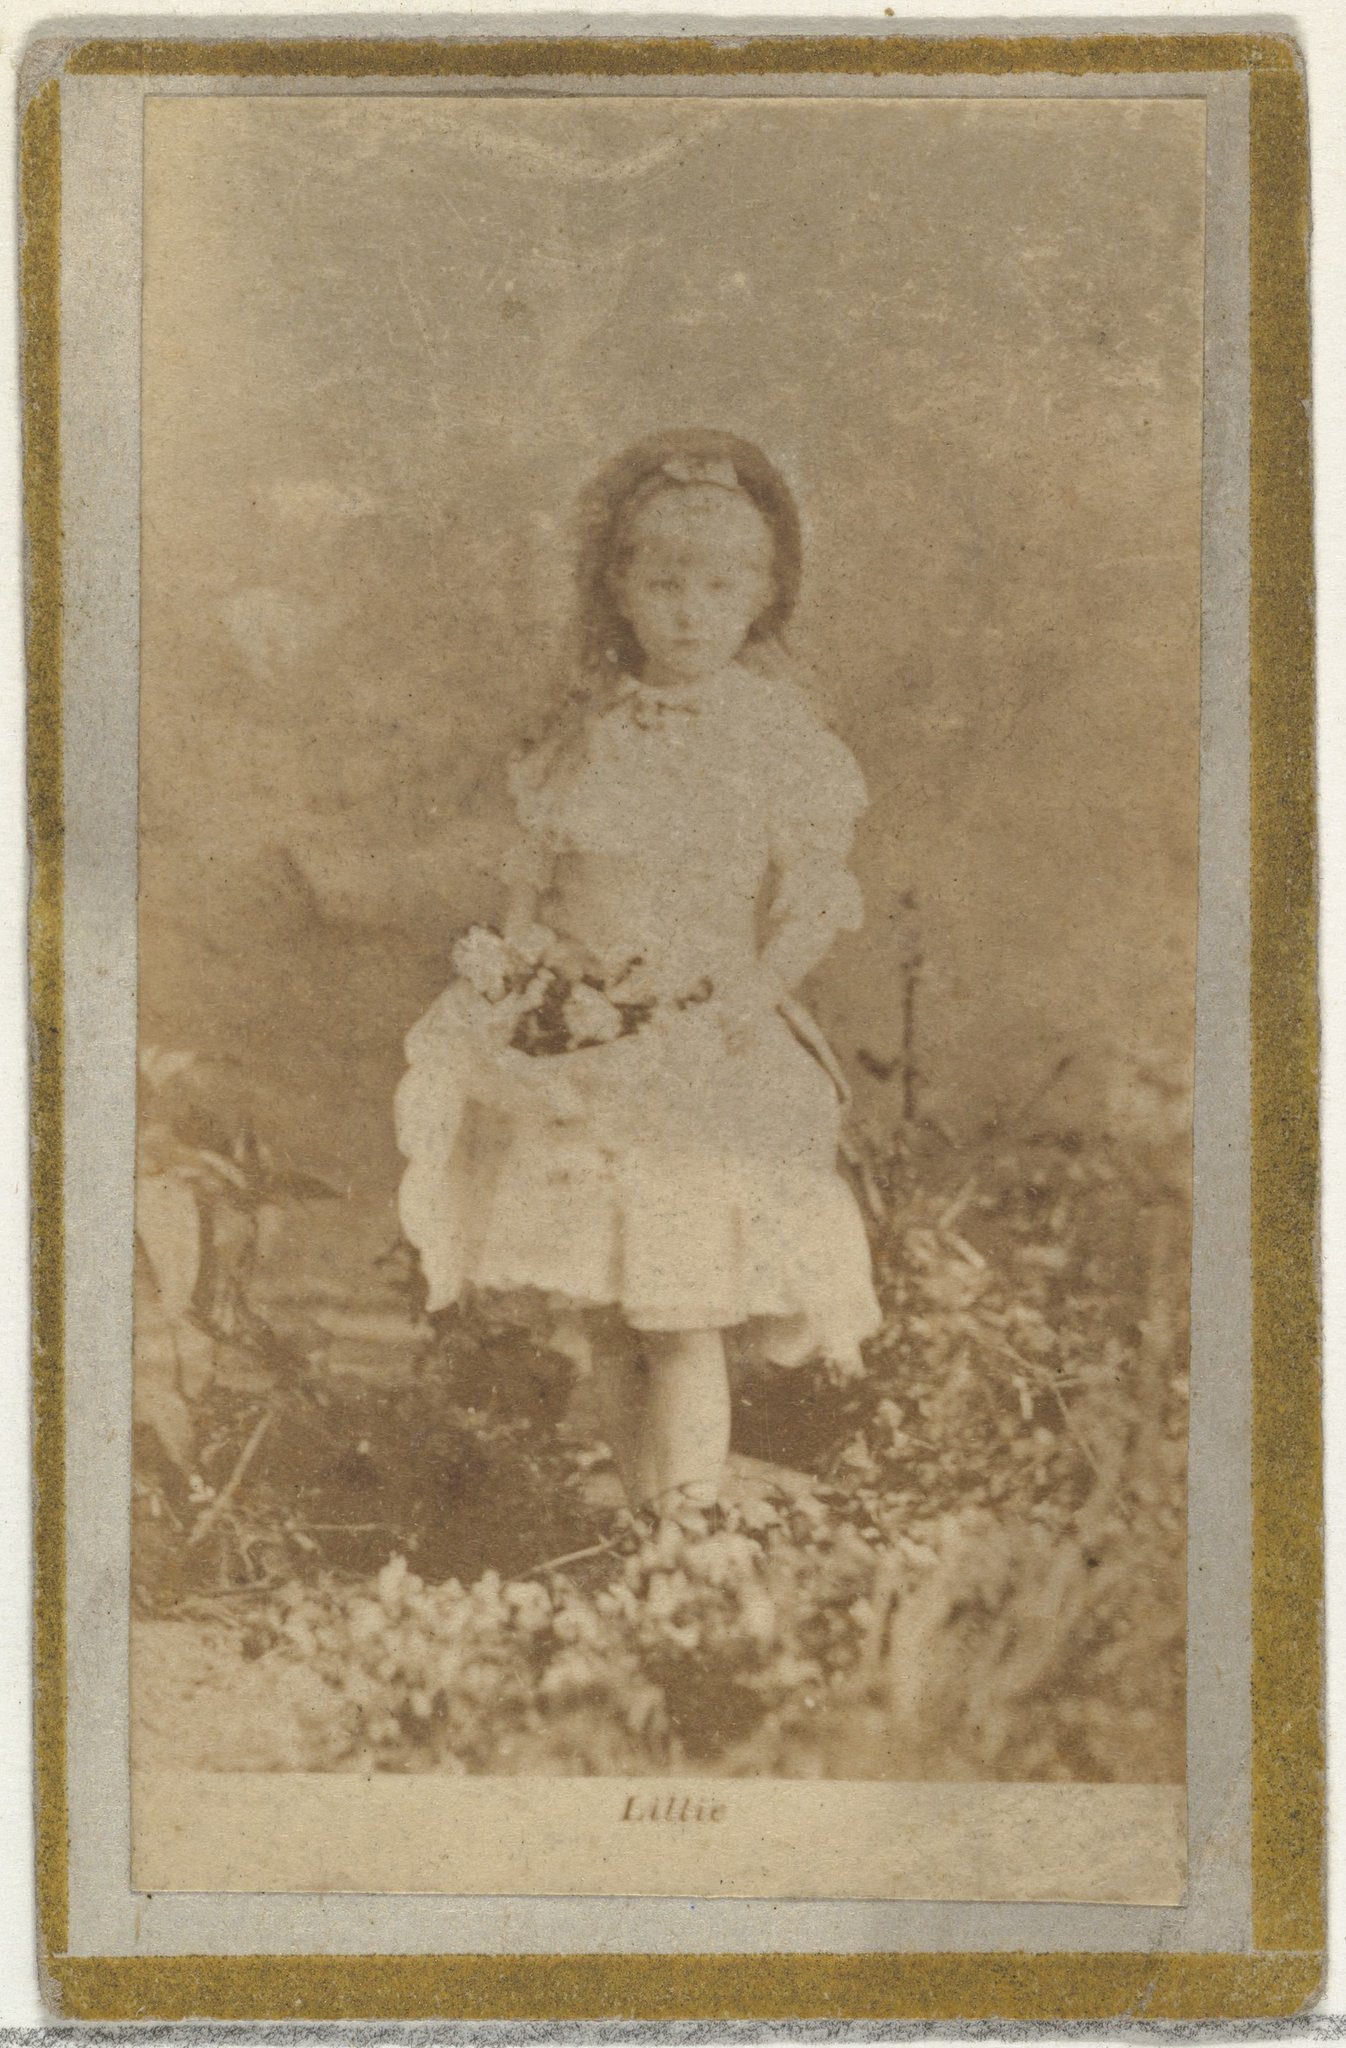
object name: photograph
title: Lillie, from the Actresses and Celebrities series (N60, Type 2) promoting Little Beauties Cigarettes for Allen & Ginter brand tobacco products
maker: allen & ginter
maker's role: publisher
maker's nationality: american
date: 1887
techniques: albumen silver print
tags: girls,portraits,actresses